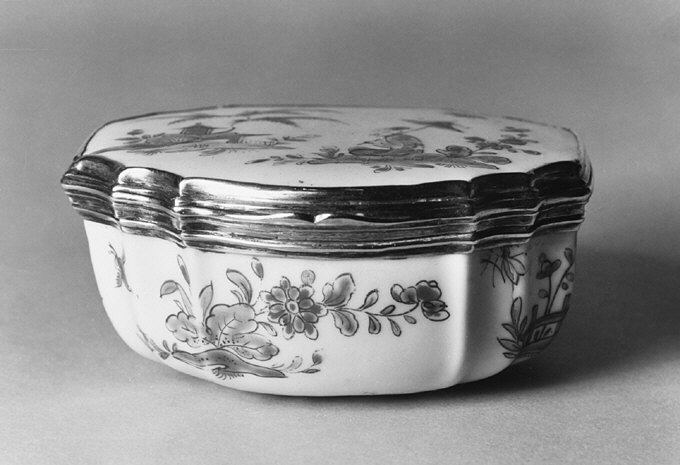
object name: snuffbox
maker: saint-cloud factory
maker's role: factory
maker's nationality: french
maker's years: 1693-1766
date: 1738-1744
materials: silver, soft paste porcelain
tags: flowers